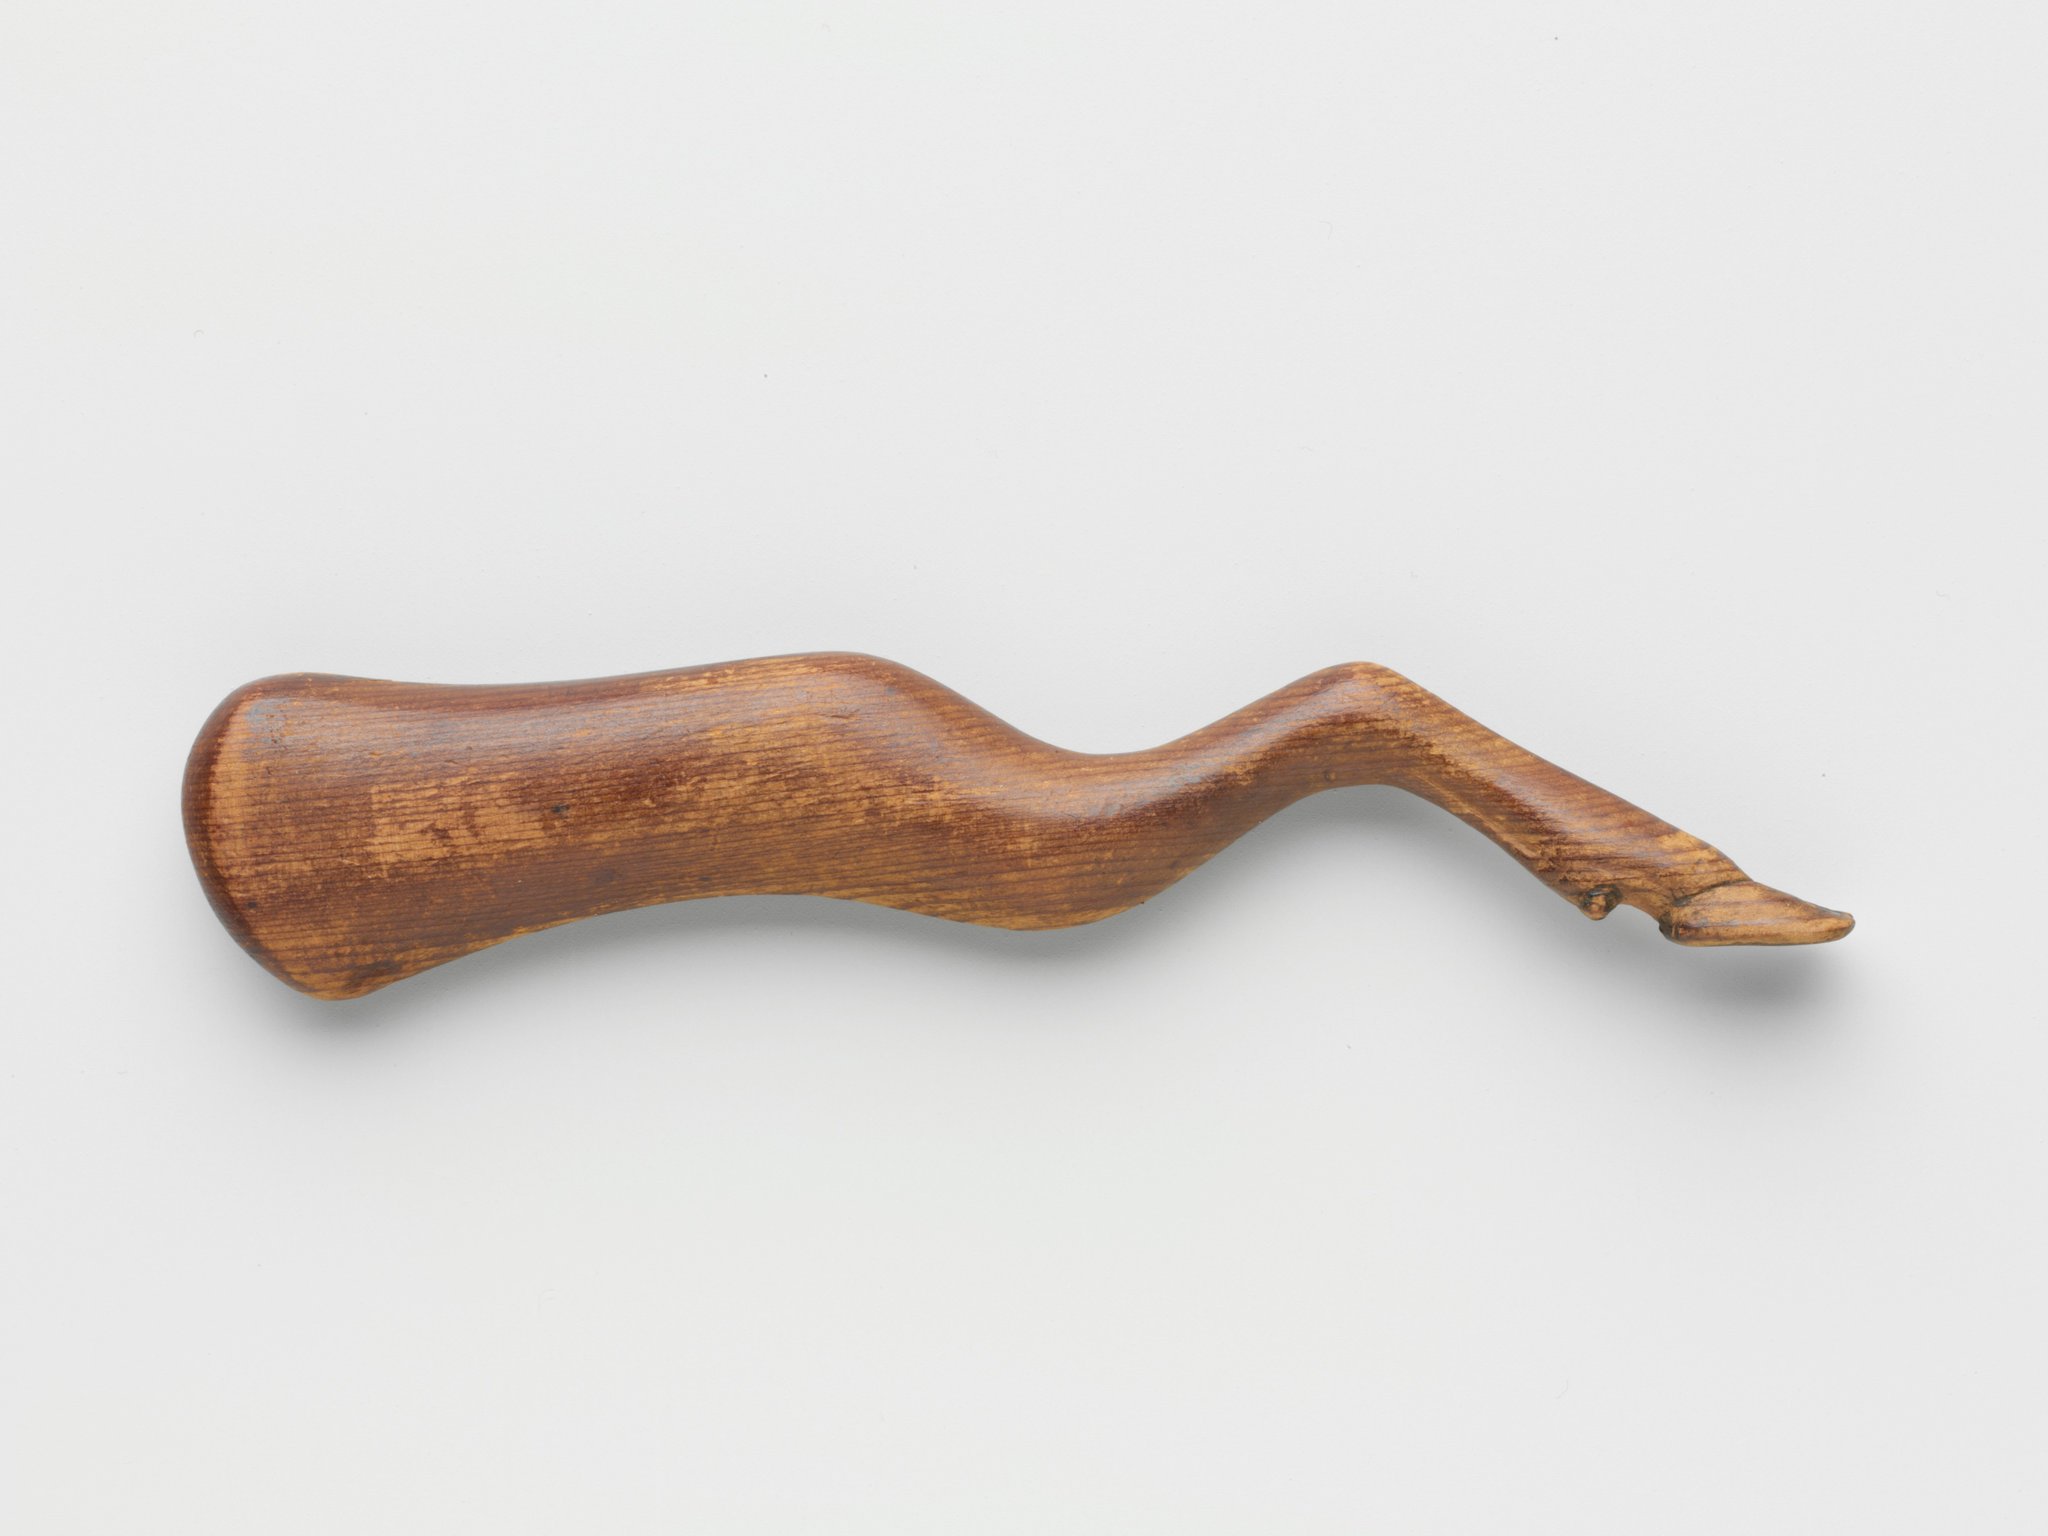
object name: model, foreleg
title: Model of the foreleg of a horned animal, perhaps from a foundation deposit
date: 1400-1295 BCE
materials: pigment, wood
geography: egypt